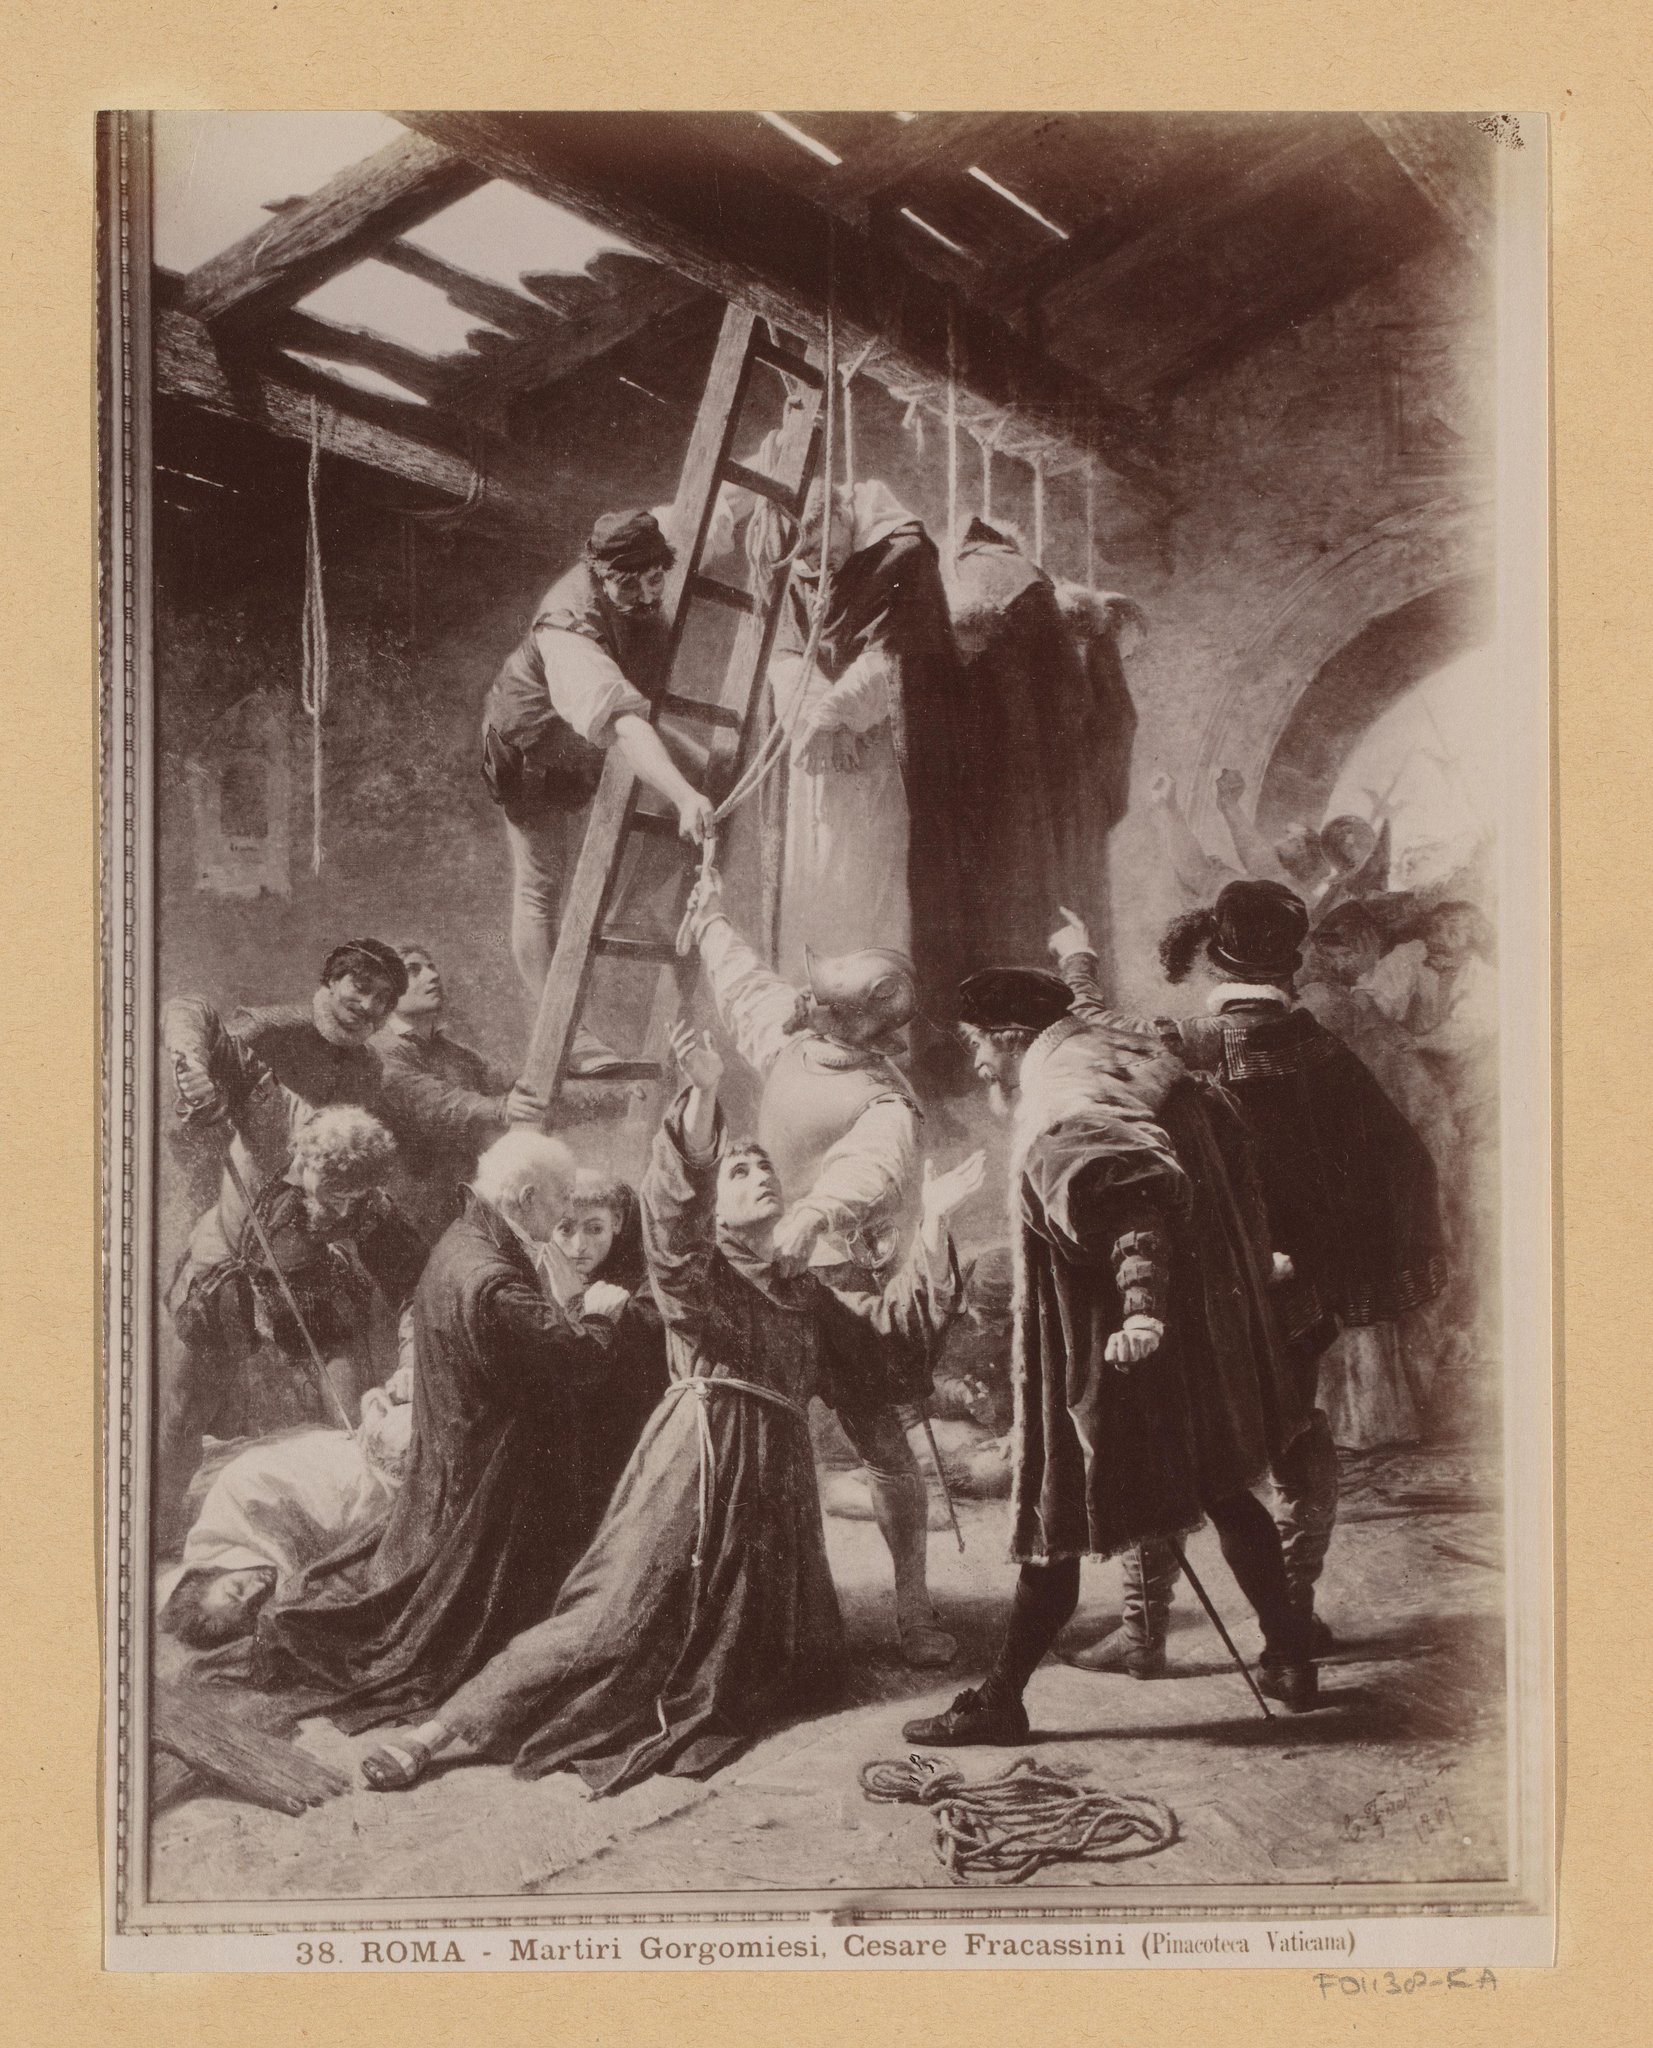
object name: reproduction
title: Fotoreproductie van een schilderij door Cesare Fracassini, voorstellend de ophanging van de Martelaren van Gorkum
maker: Anonymous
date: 1867-1900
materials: photographic support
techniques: albumen print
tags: nineteen friars of different orders are taken prisoner and hanged by 'watergeuzen' (beggars of the sea) after the capture of gorkum (in holland)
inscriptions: number: ‘38’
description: Onderdeel van Reisalbum met opnames van kunstwerken en bezienswaardigheden in Italië, Griekenland en Frankrijk.